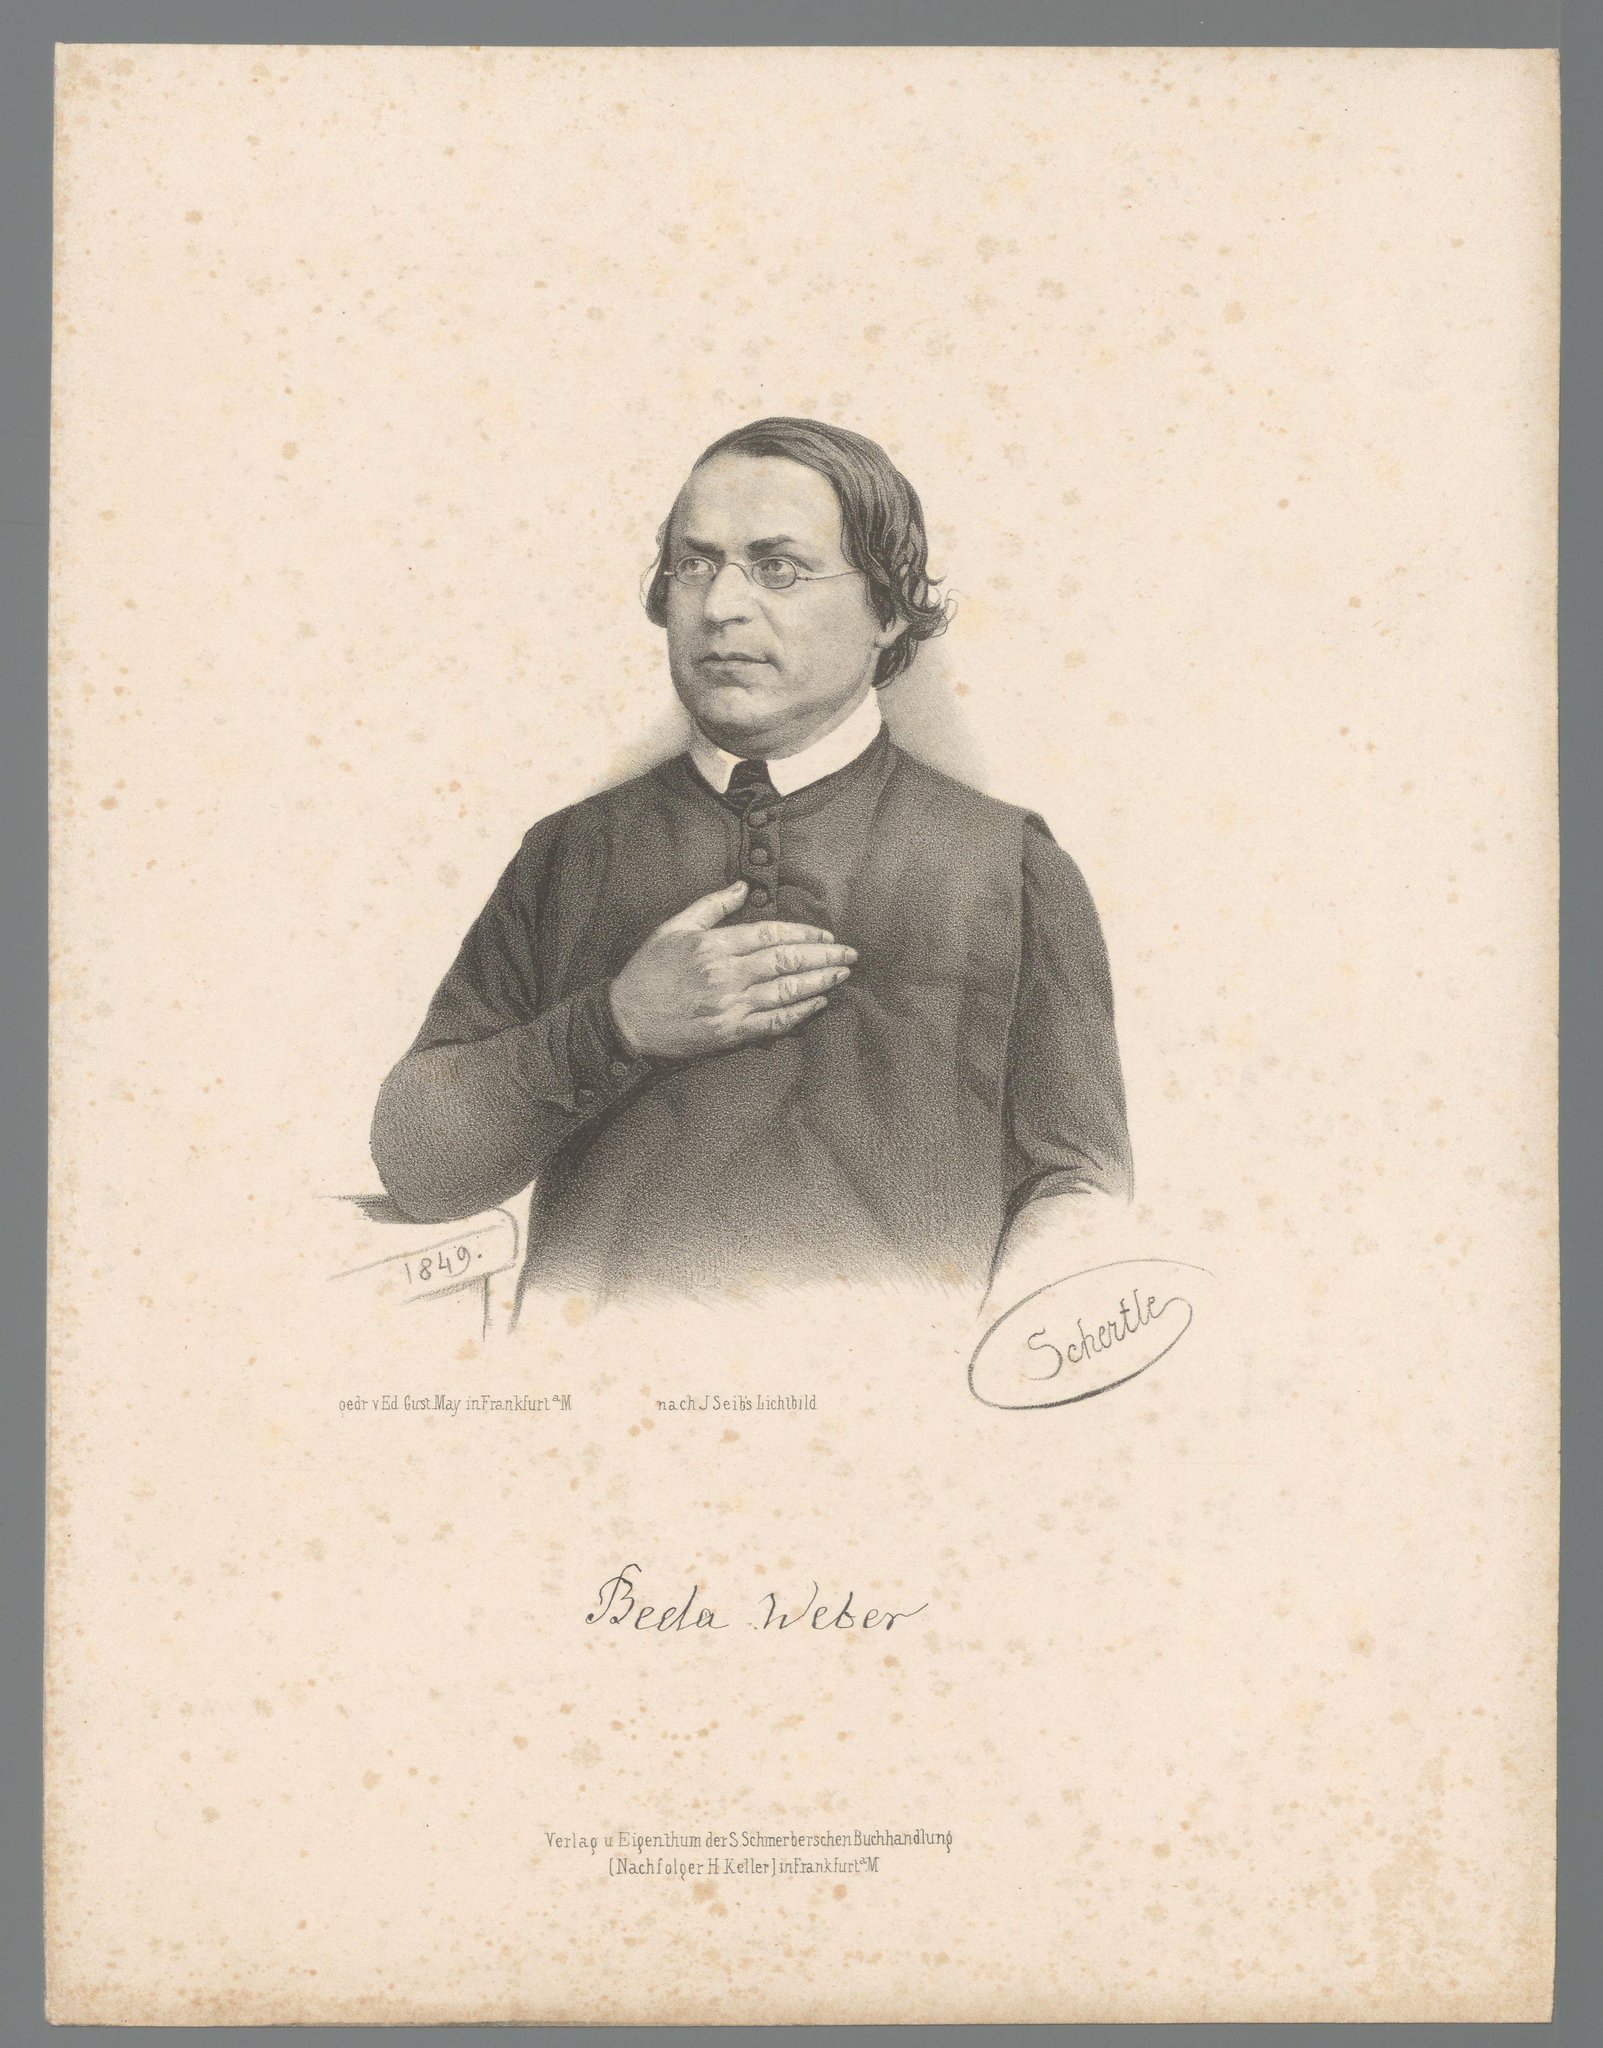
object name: print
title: Portretten van Duitse mannen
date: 1849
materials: paper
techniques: lithograph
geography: frankfurt am main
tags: eyeglasses, spectacles, adult man, historical persons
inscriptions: collector's mark: Lugt 2228